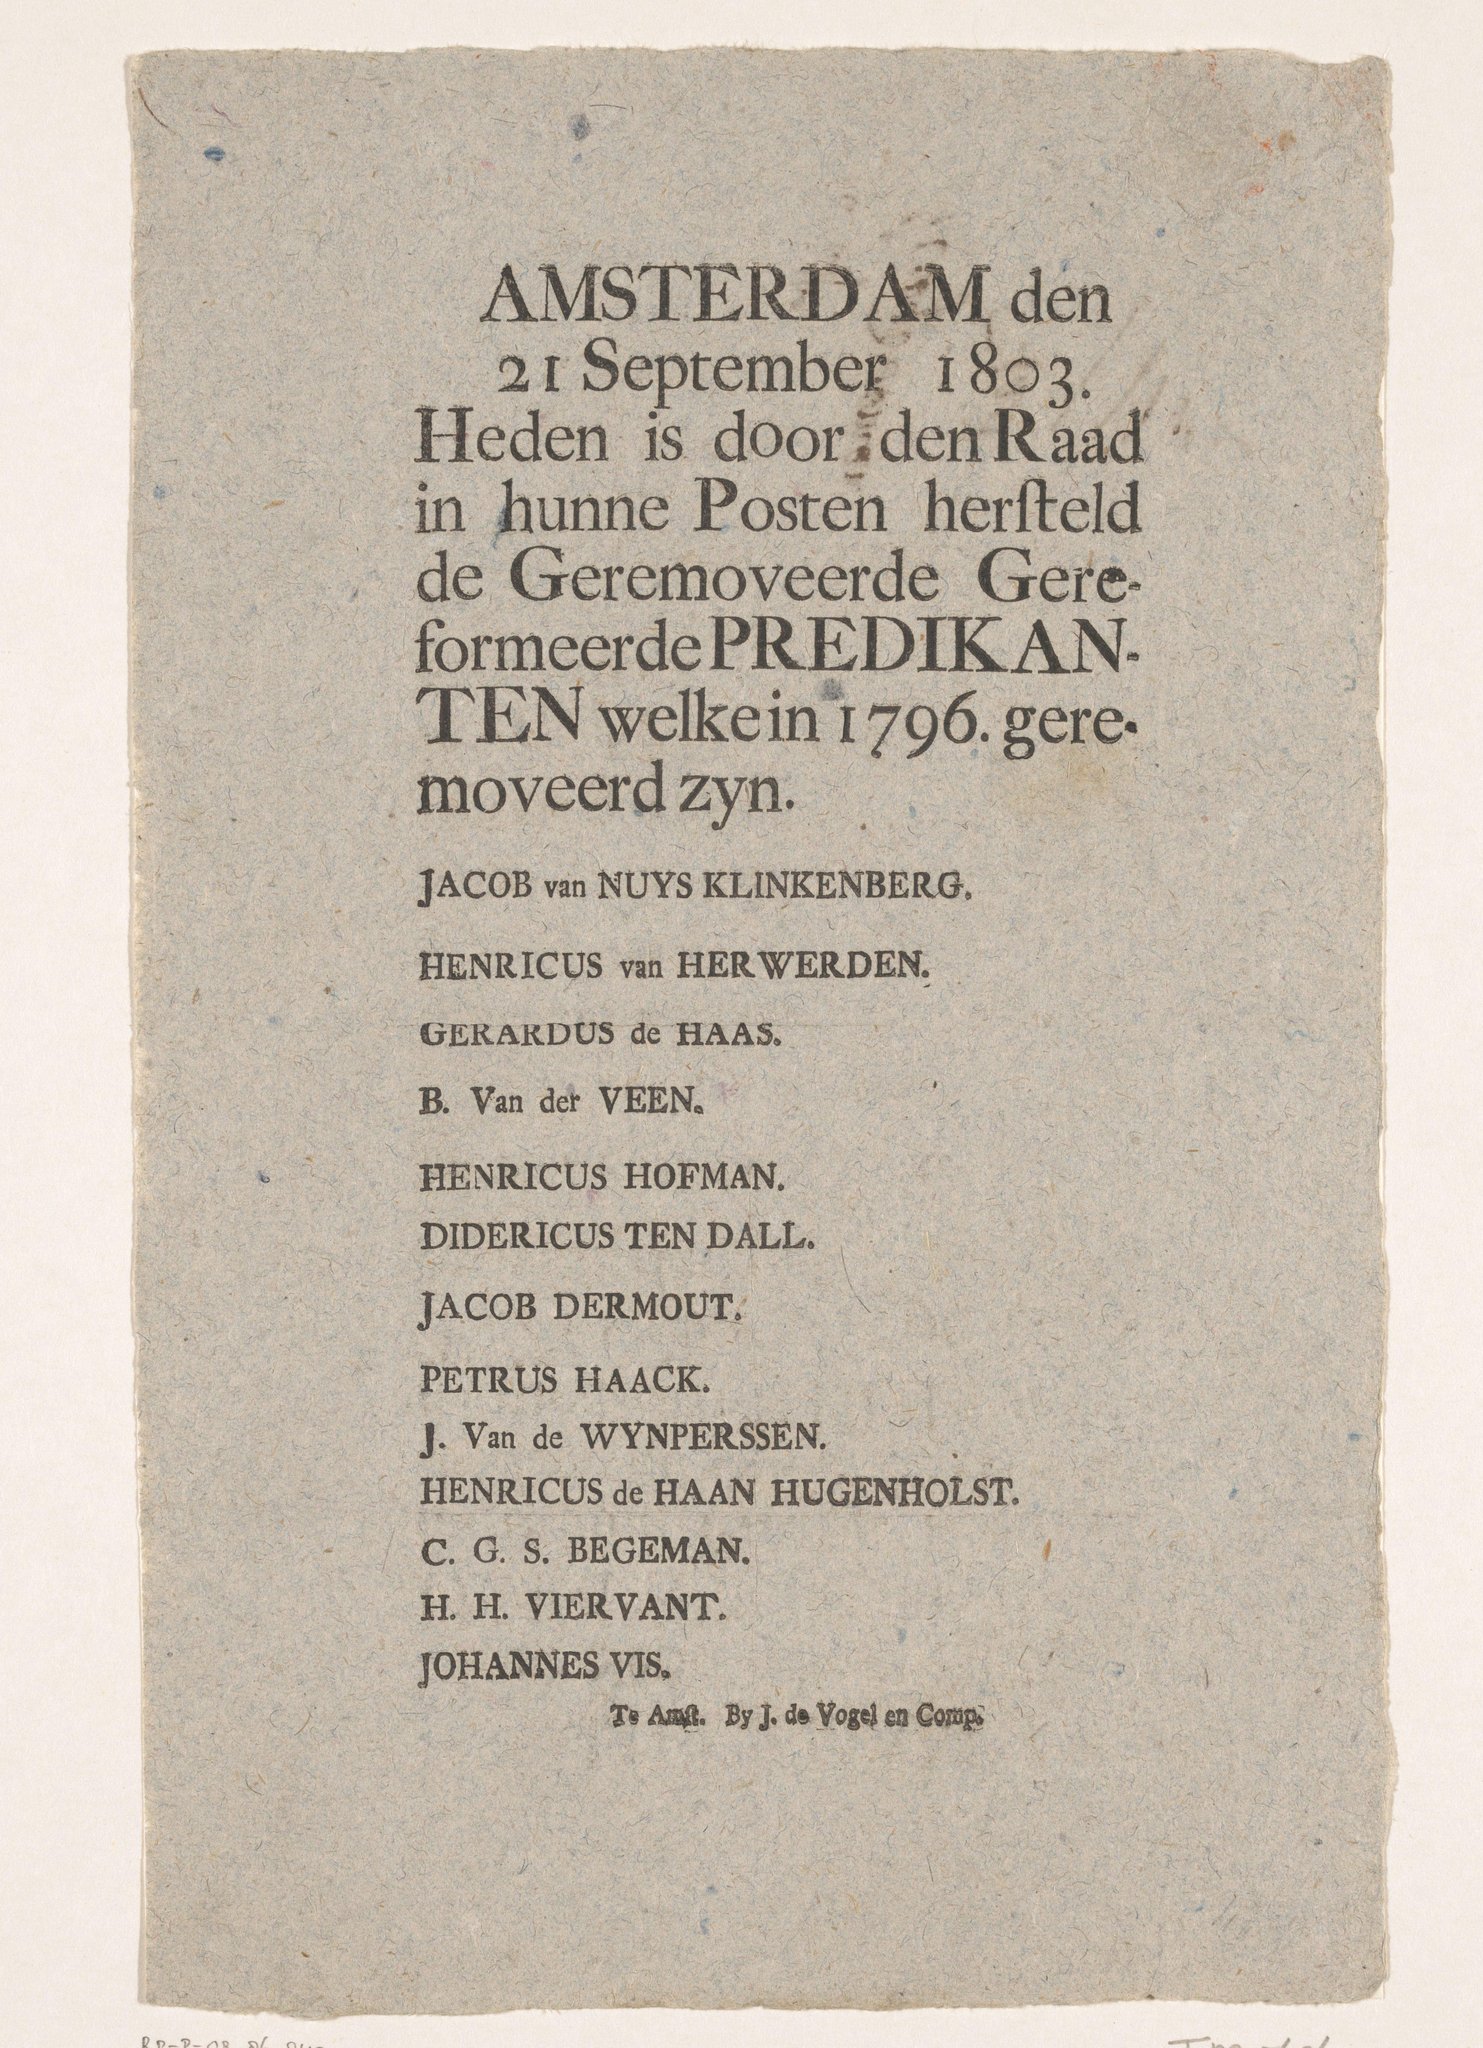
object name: text sheet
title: Gedrukte lijst van de namen van de in 1796 geremoveerde gereformeerde predikanten, 1803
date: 1803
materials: paper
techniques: letterpress printing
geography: amsterdam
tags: amsterdam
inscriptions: annotation: ‘Mejuffw. Muyderman Hall’, collector's mark: Lugt 2228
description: Gedrukte lijst van de namen van dertien (van de vijftien) van de gereformeerde predikanten die in 1796 uit hun ambt waren gezet omdat zij de eed weigerden af te leggen en die op 21 september 1803 door de raad te Amsterdam weer in hun ambt zijn hersteld.